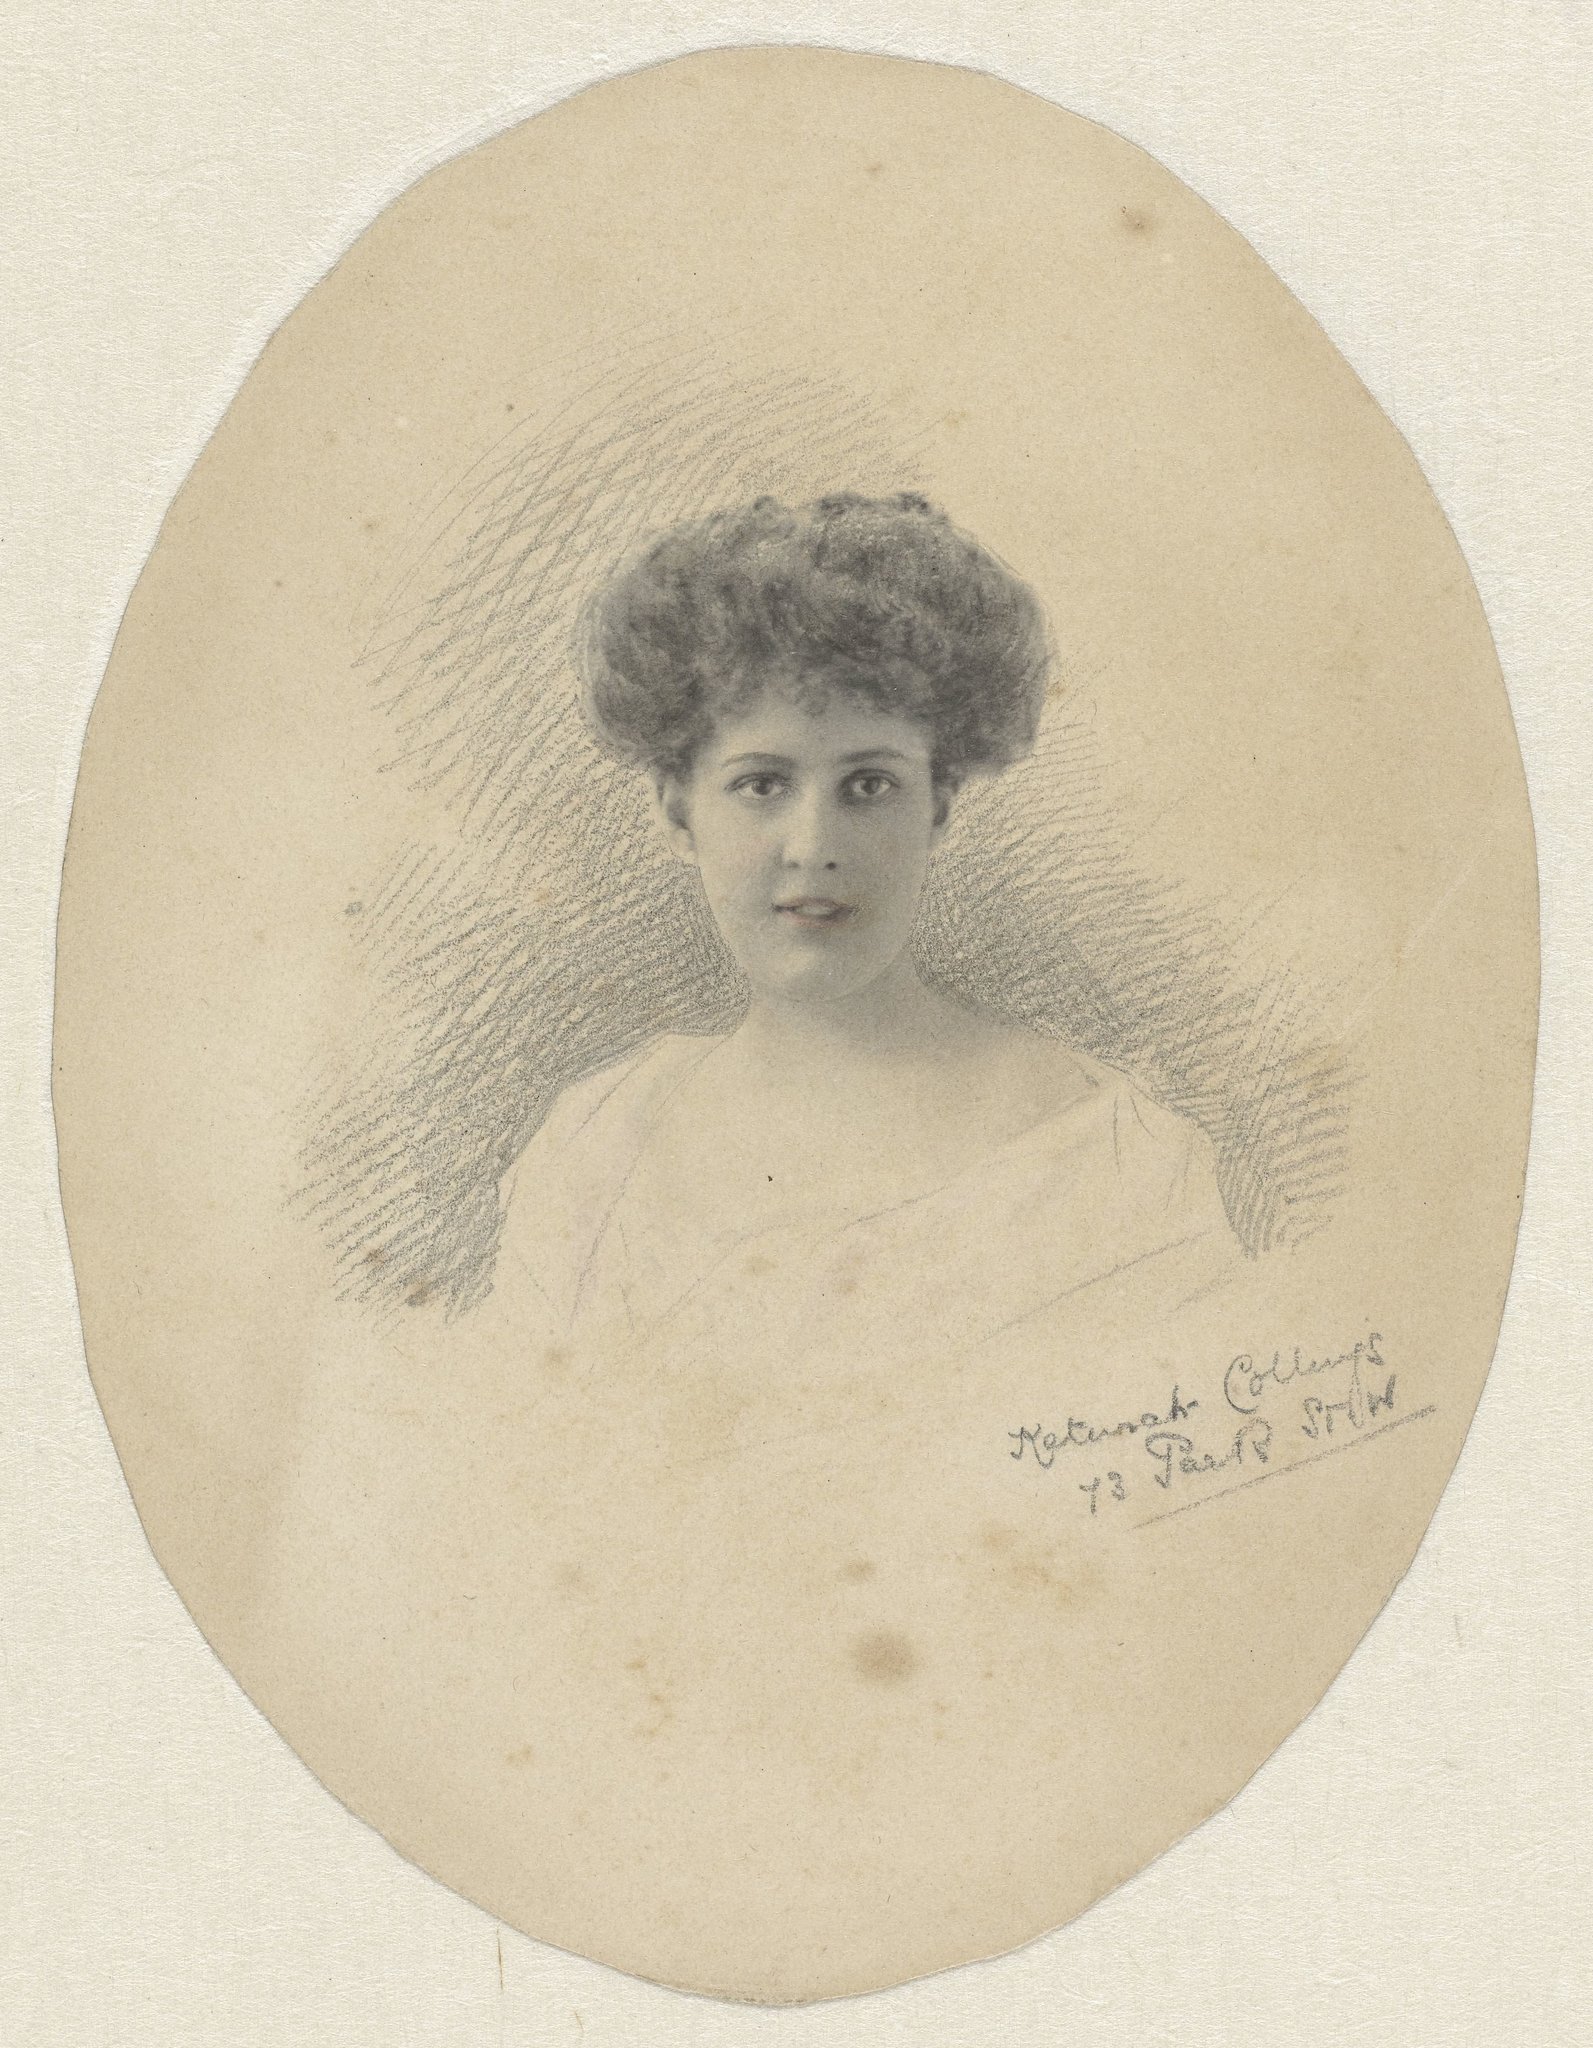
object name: photograph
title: Ovaal portret van mevrouw Heemstra-Hollenberg de Beckfeldt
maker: keturah collings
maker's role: fotograaf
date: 1905-1914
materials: photographic support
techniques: hand coloring, platinum process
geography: great britain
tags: adult woman, anonymous historical person portrayed, great britain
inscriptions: address: ‘73 Park Stow’, number: ‘2805’